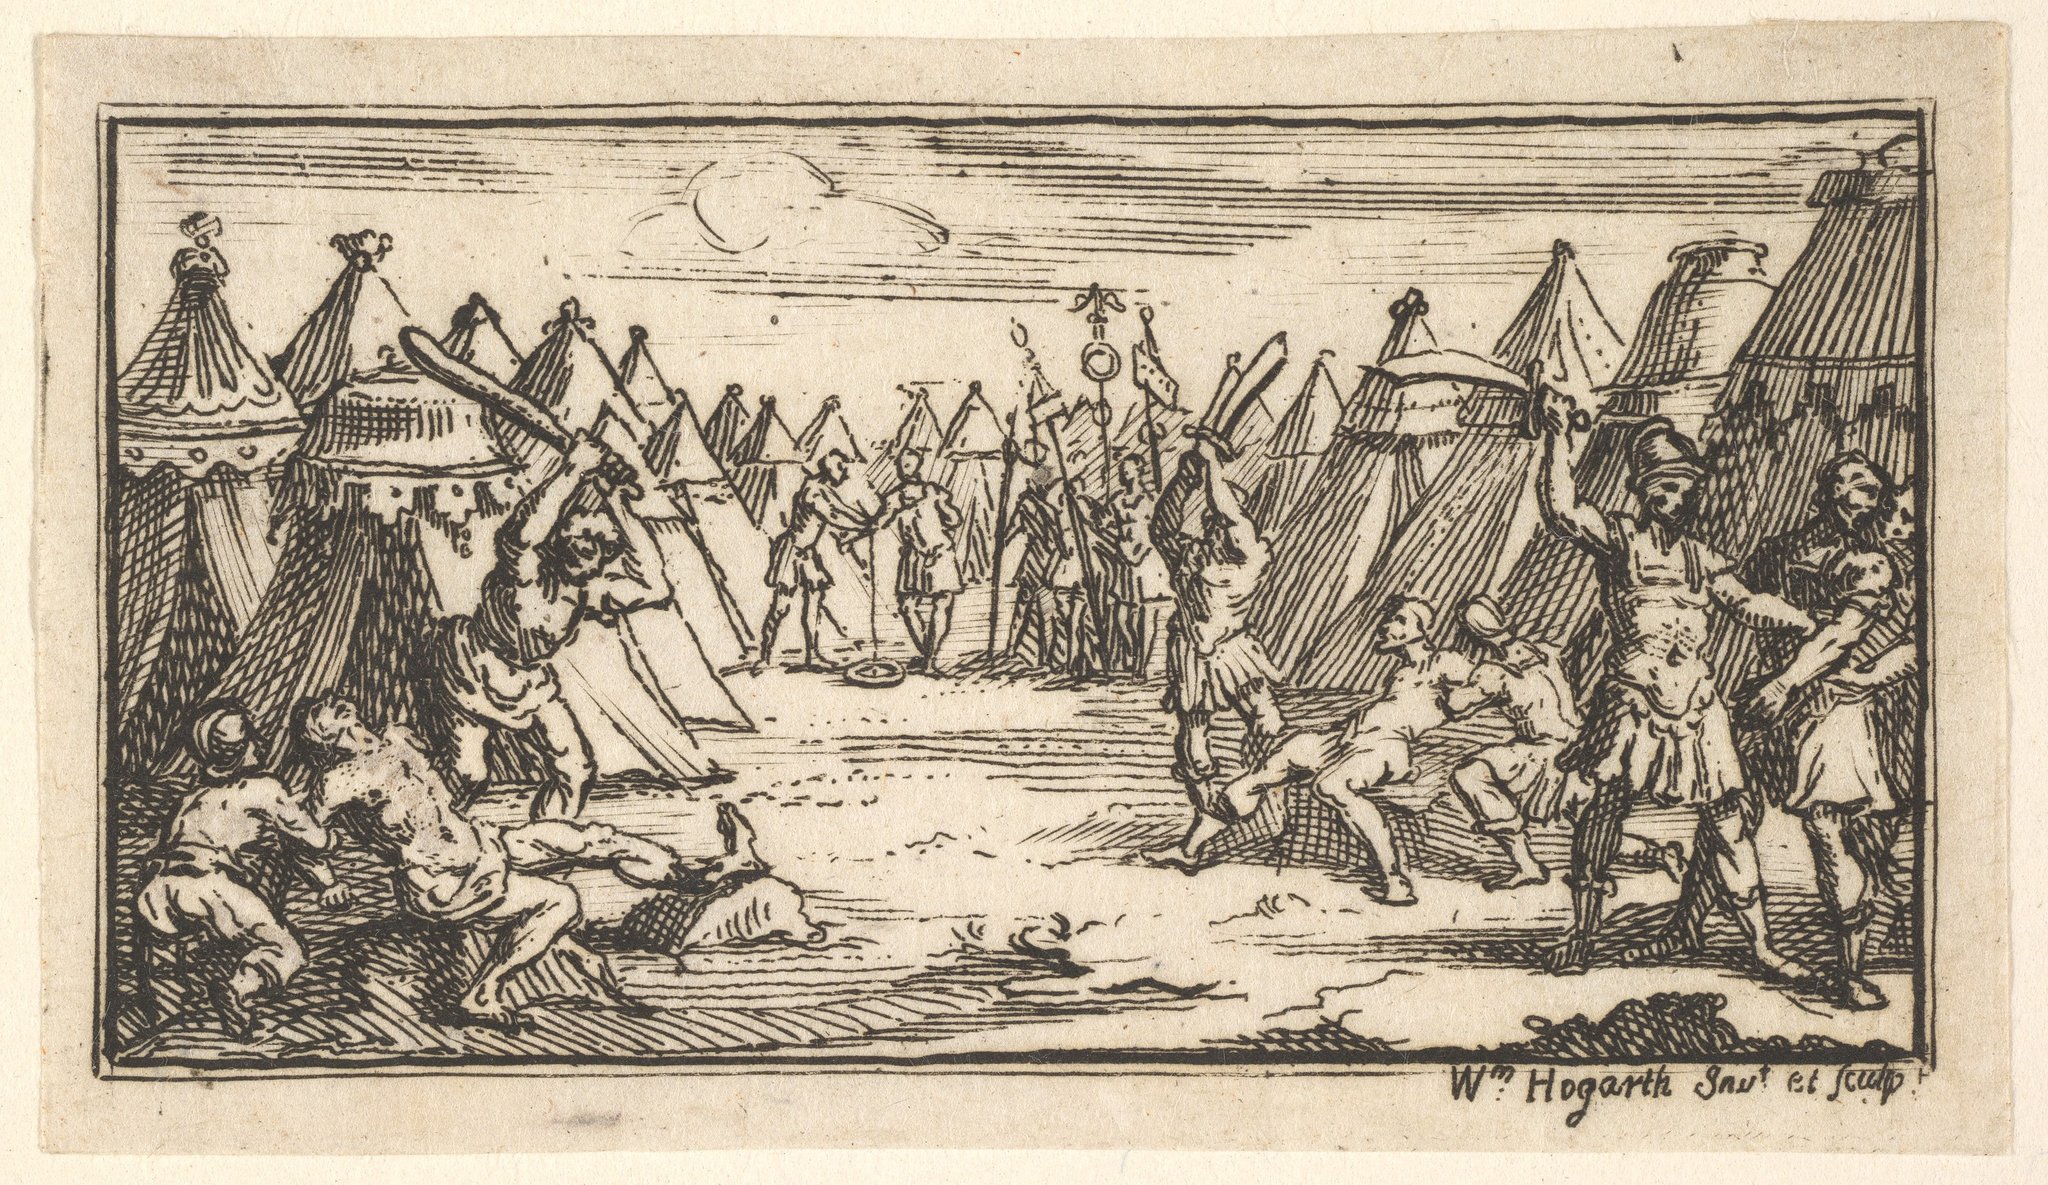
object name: print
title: Breaking the Legs (John Beaver, Roman Military Punishments, 1725)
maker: william hogarth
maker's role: artist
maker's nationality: british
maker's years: 1697-1764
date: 1725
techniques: etching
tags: tents,military,swords,men,punishment